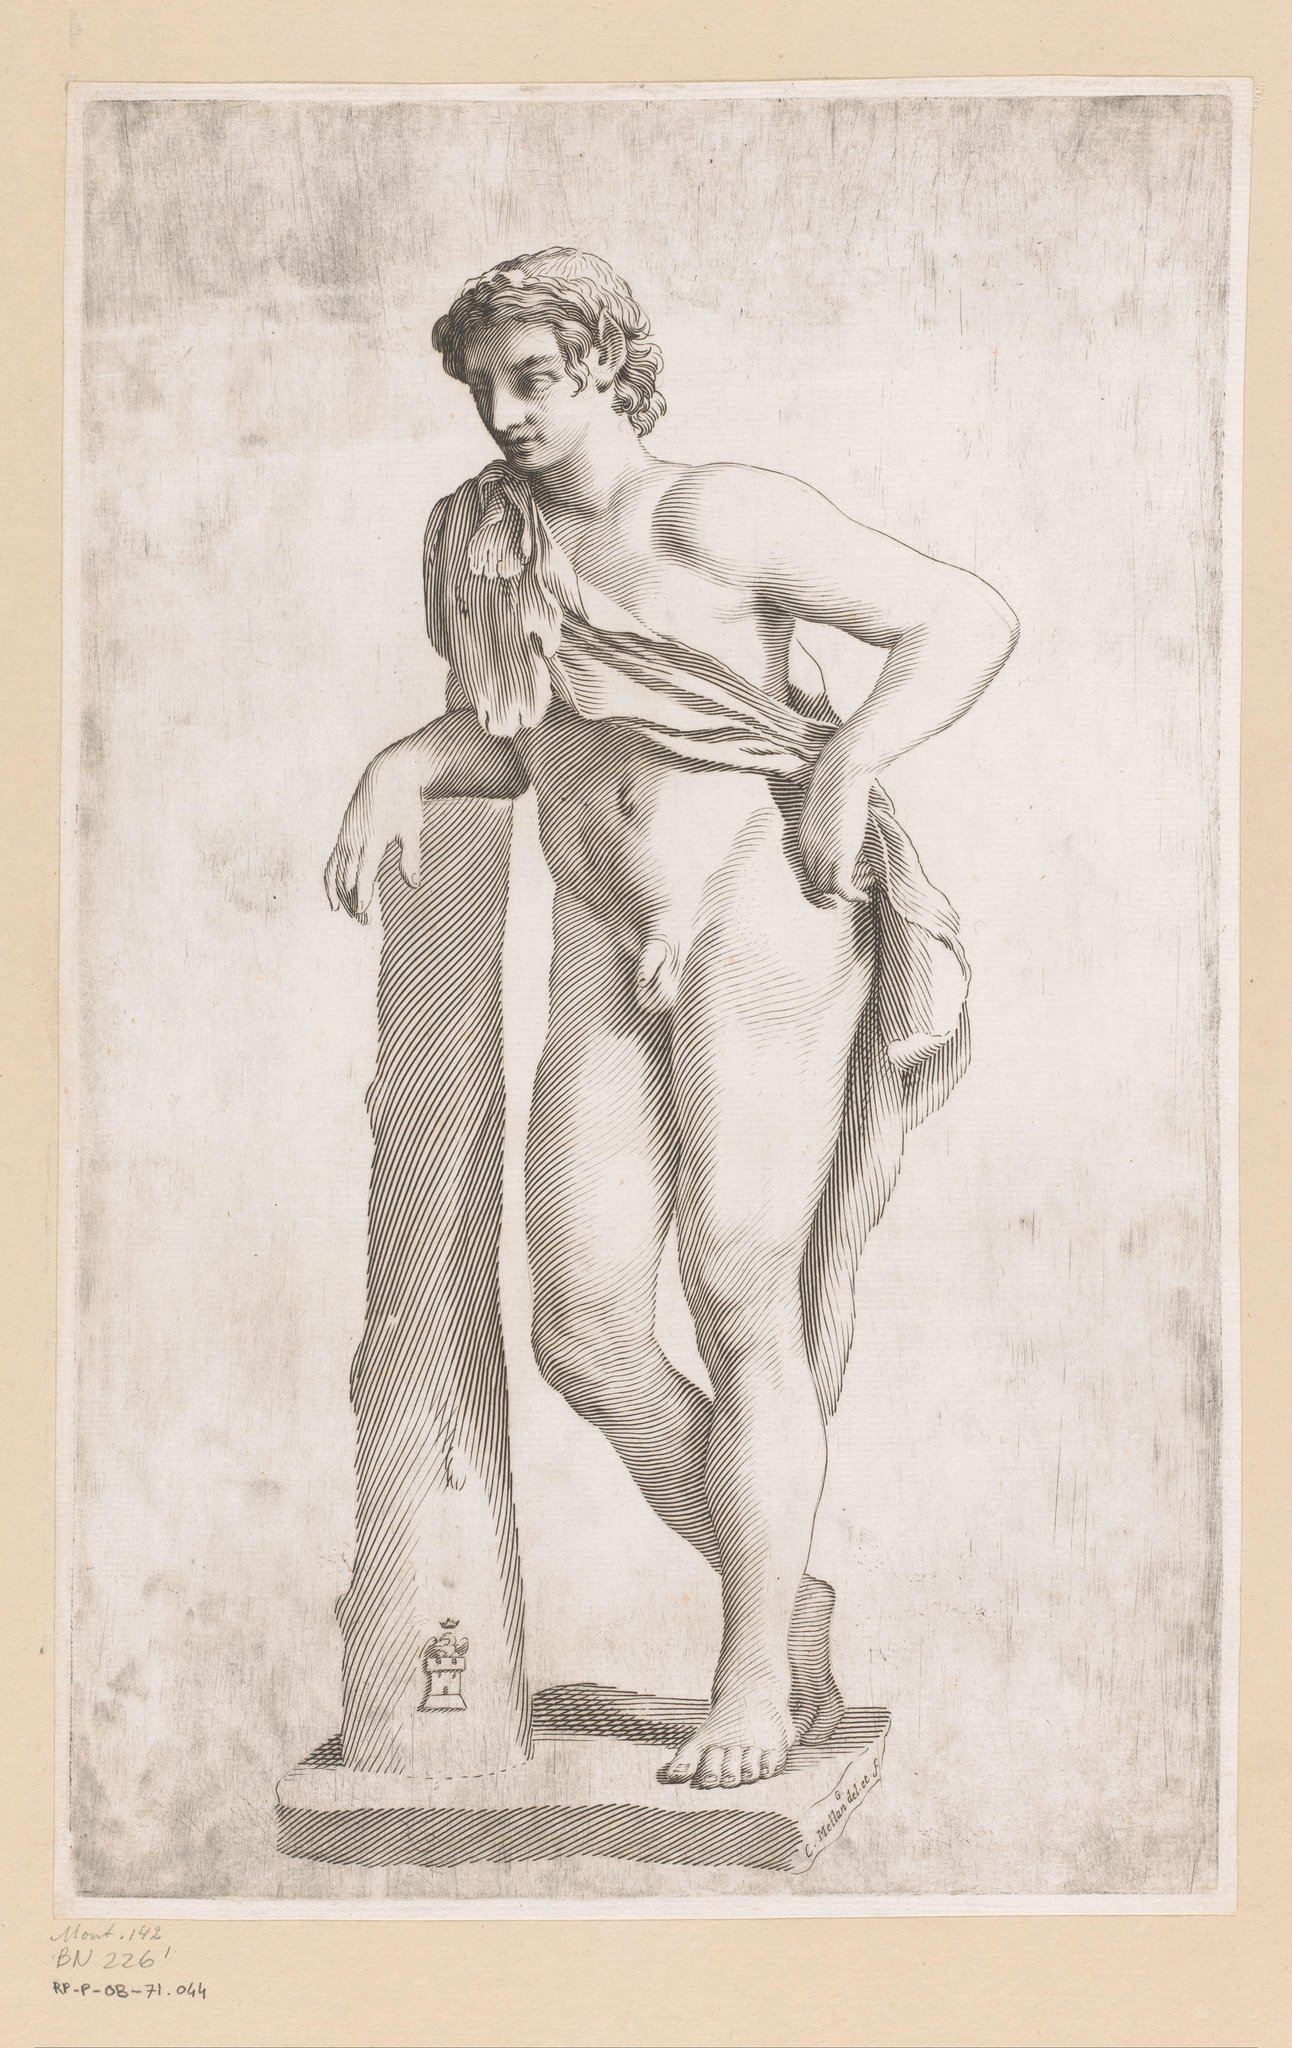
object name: print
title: Galleria Giustiniana del Marchese Vincenzo Giustiniani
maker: claude mellan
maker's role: draughtsman, print maker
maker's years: 1598-1688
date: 1631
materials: paper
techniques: engraving, intaglio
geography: rome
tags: rome, vincenzo giustiniani (1564-1637), satyrs, fauns, sileni, piece of sculpture, reproduction of a piece of sculpture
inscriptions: collector's mark: Lugt 240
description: Maakt deel uit van een serie bestaande uit 322 prenten van kunstwerken uit de collectie van Vincenzo Giustiniani die in twee volumes werd uitgegeven door Joachim von Sandrart in 1636 en 1637 (zie British Museum, inv.nr. 1851,1213.565). De serie bestaat uit prenten door verschillende kunstenaars zoals Cornelis Bloemaert, Theodore Matham, Pieter de Bailliu en Michel Natalis. Claude Mellan was verantwoordelijk voor 22 prenten van standbeelden en het 1631 gedateerde portret van Giustiniani.